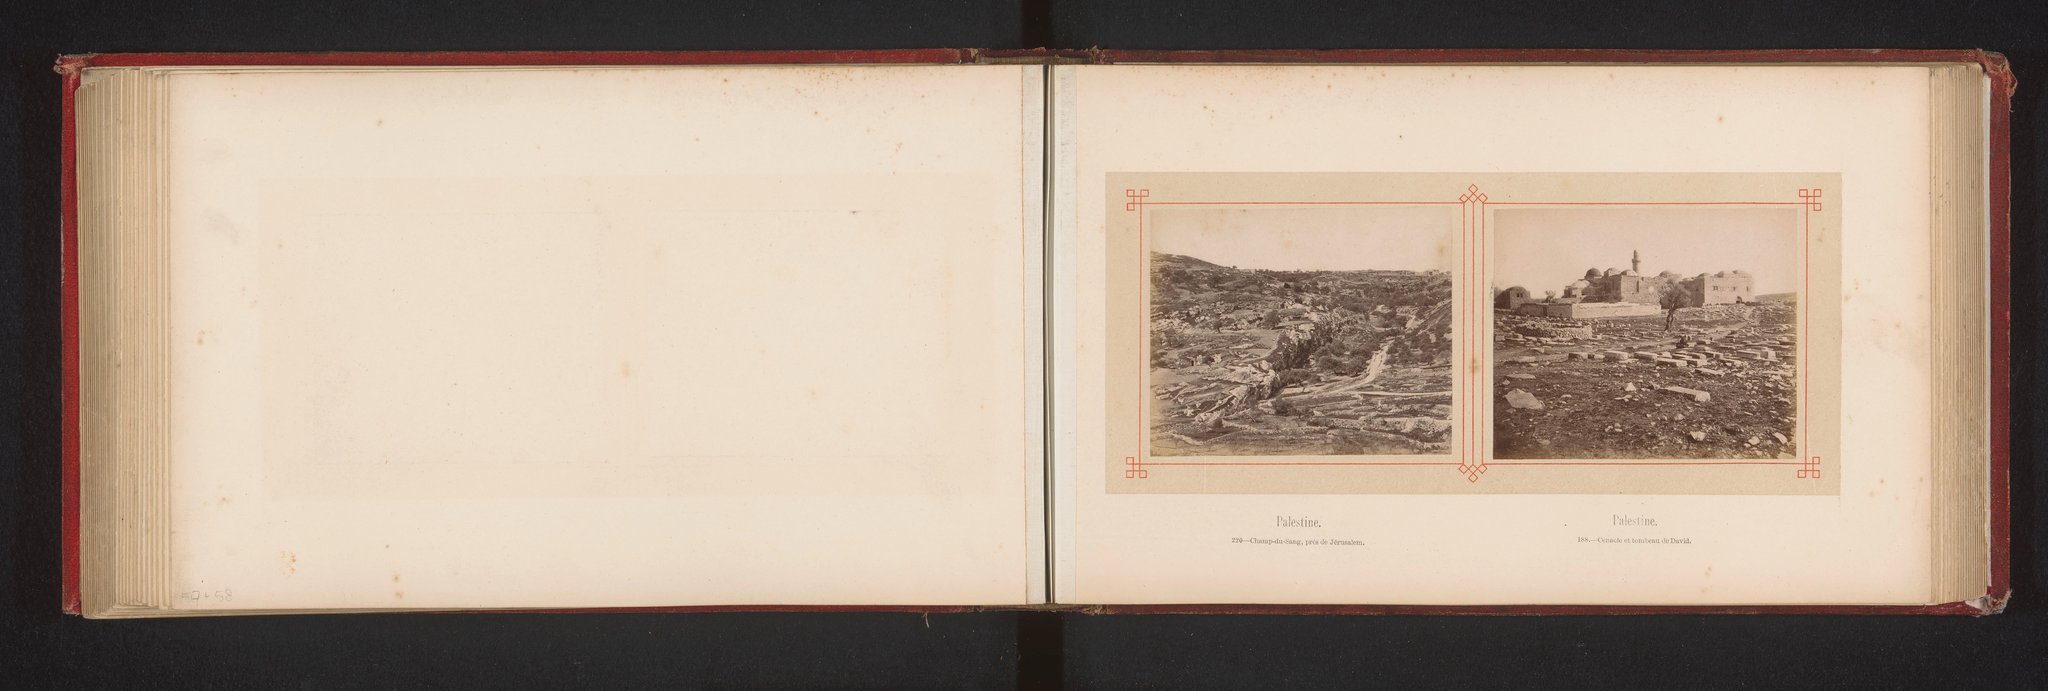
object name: page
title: Gezicht op Akeldama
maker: félix bonfils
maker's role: fotograaf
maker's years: 1831-1885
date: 1873-1878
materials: photographic support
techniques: albumen print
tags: landscapes